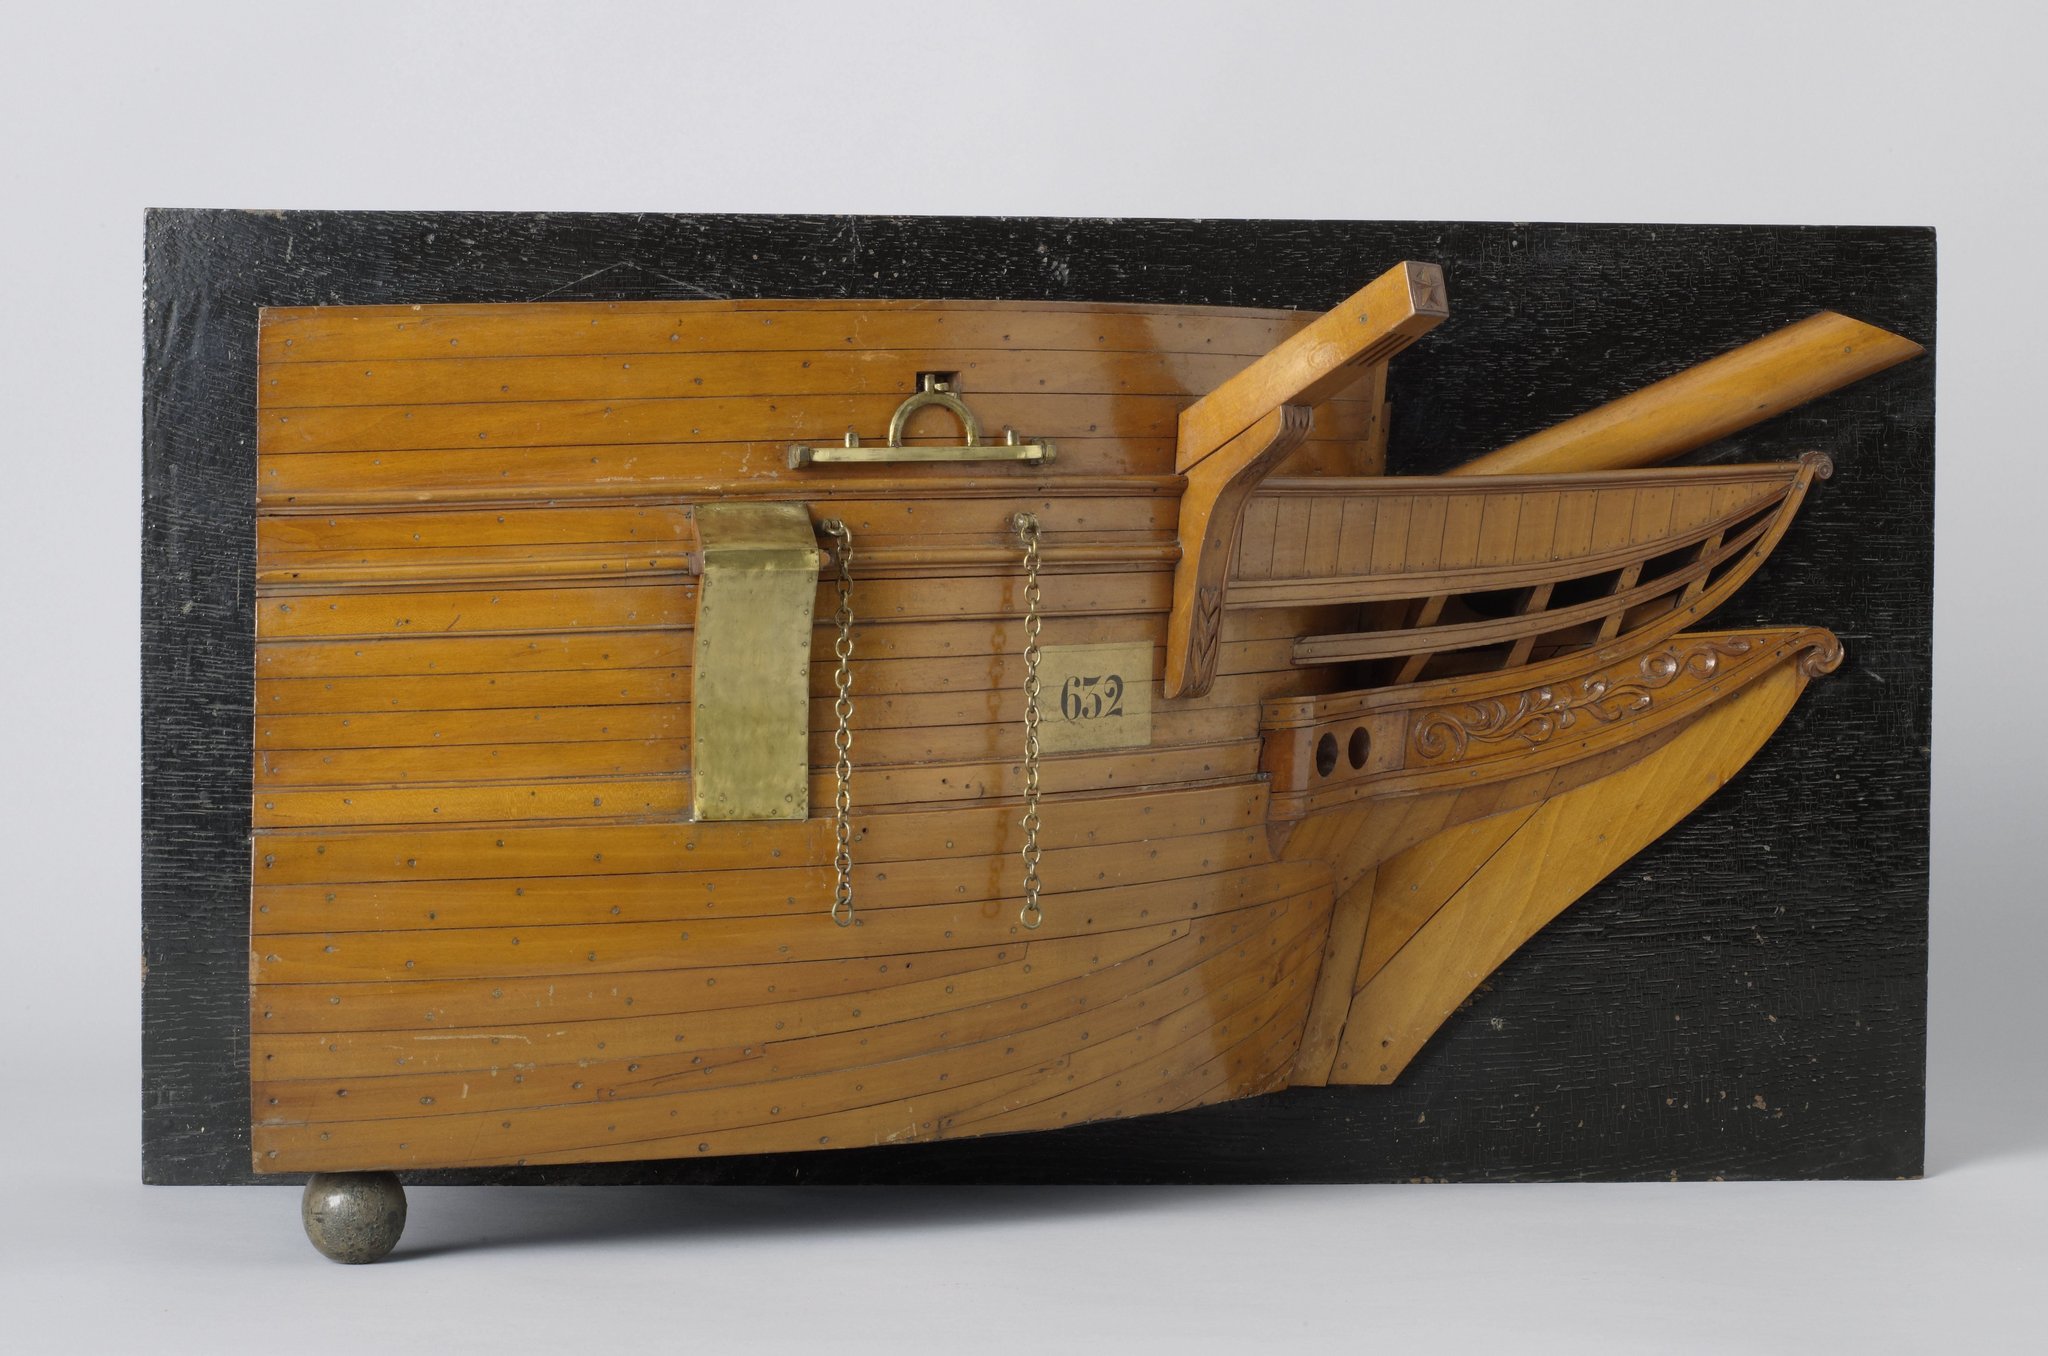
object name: demonstration model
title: Model of an Anchor Release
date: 1836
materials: brass, wood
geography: karlberg palace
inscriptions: label: ‘632’ former inventory label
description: Halfmodel en blokmodel van een voorschip boven de waterlijn, waarop een ankerval gedemonstreerd wordt. Anker en ankertouw ontbreken. Het anker moet worden opgehangen in twee kettingen, die teruggeslagen worden op een valmechaniek tegen de zijde van het schip; als dit losgemaakt wordt, vallen de kettingen open en laten het anker gaan.